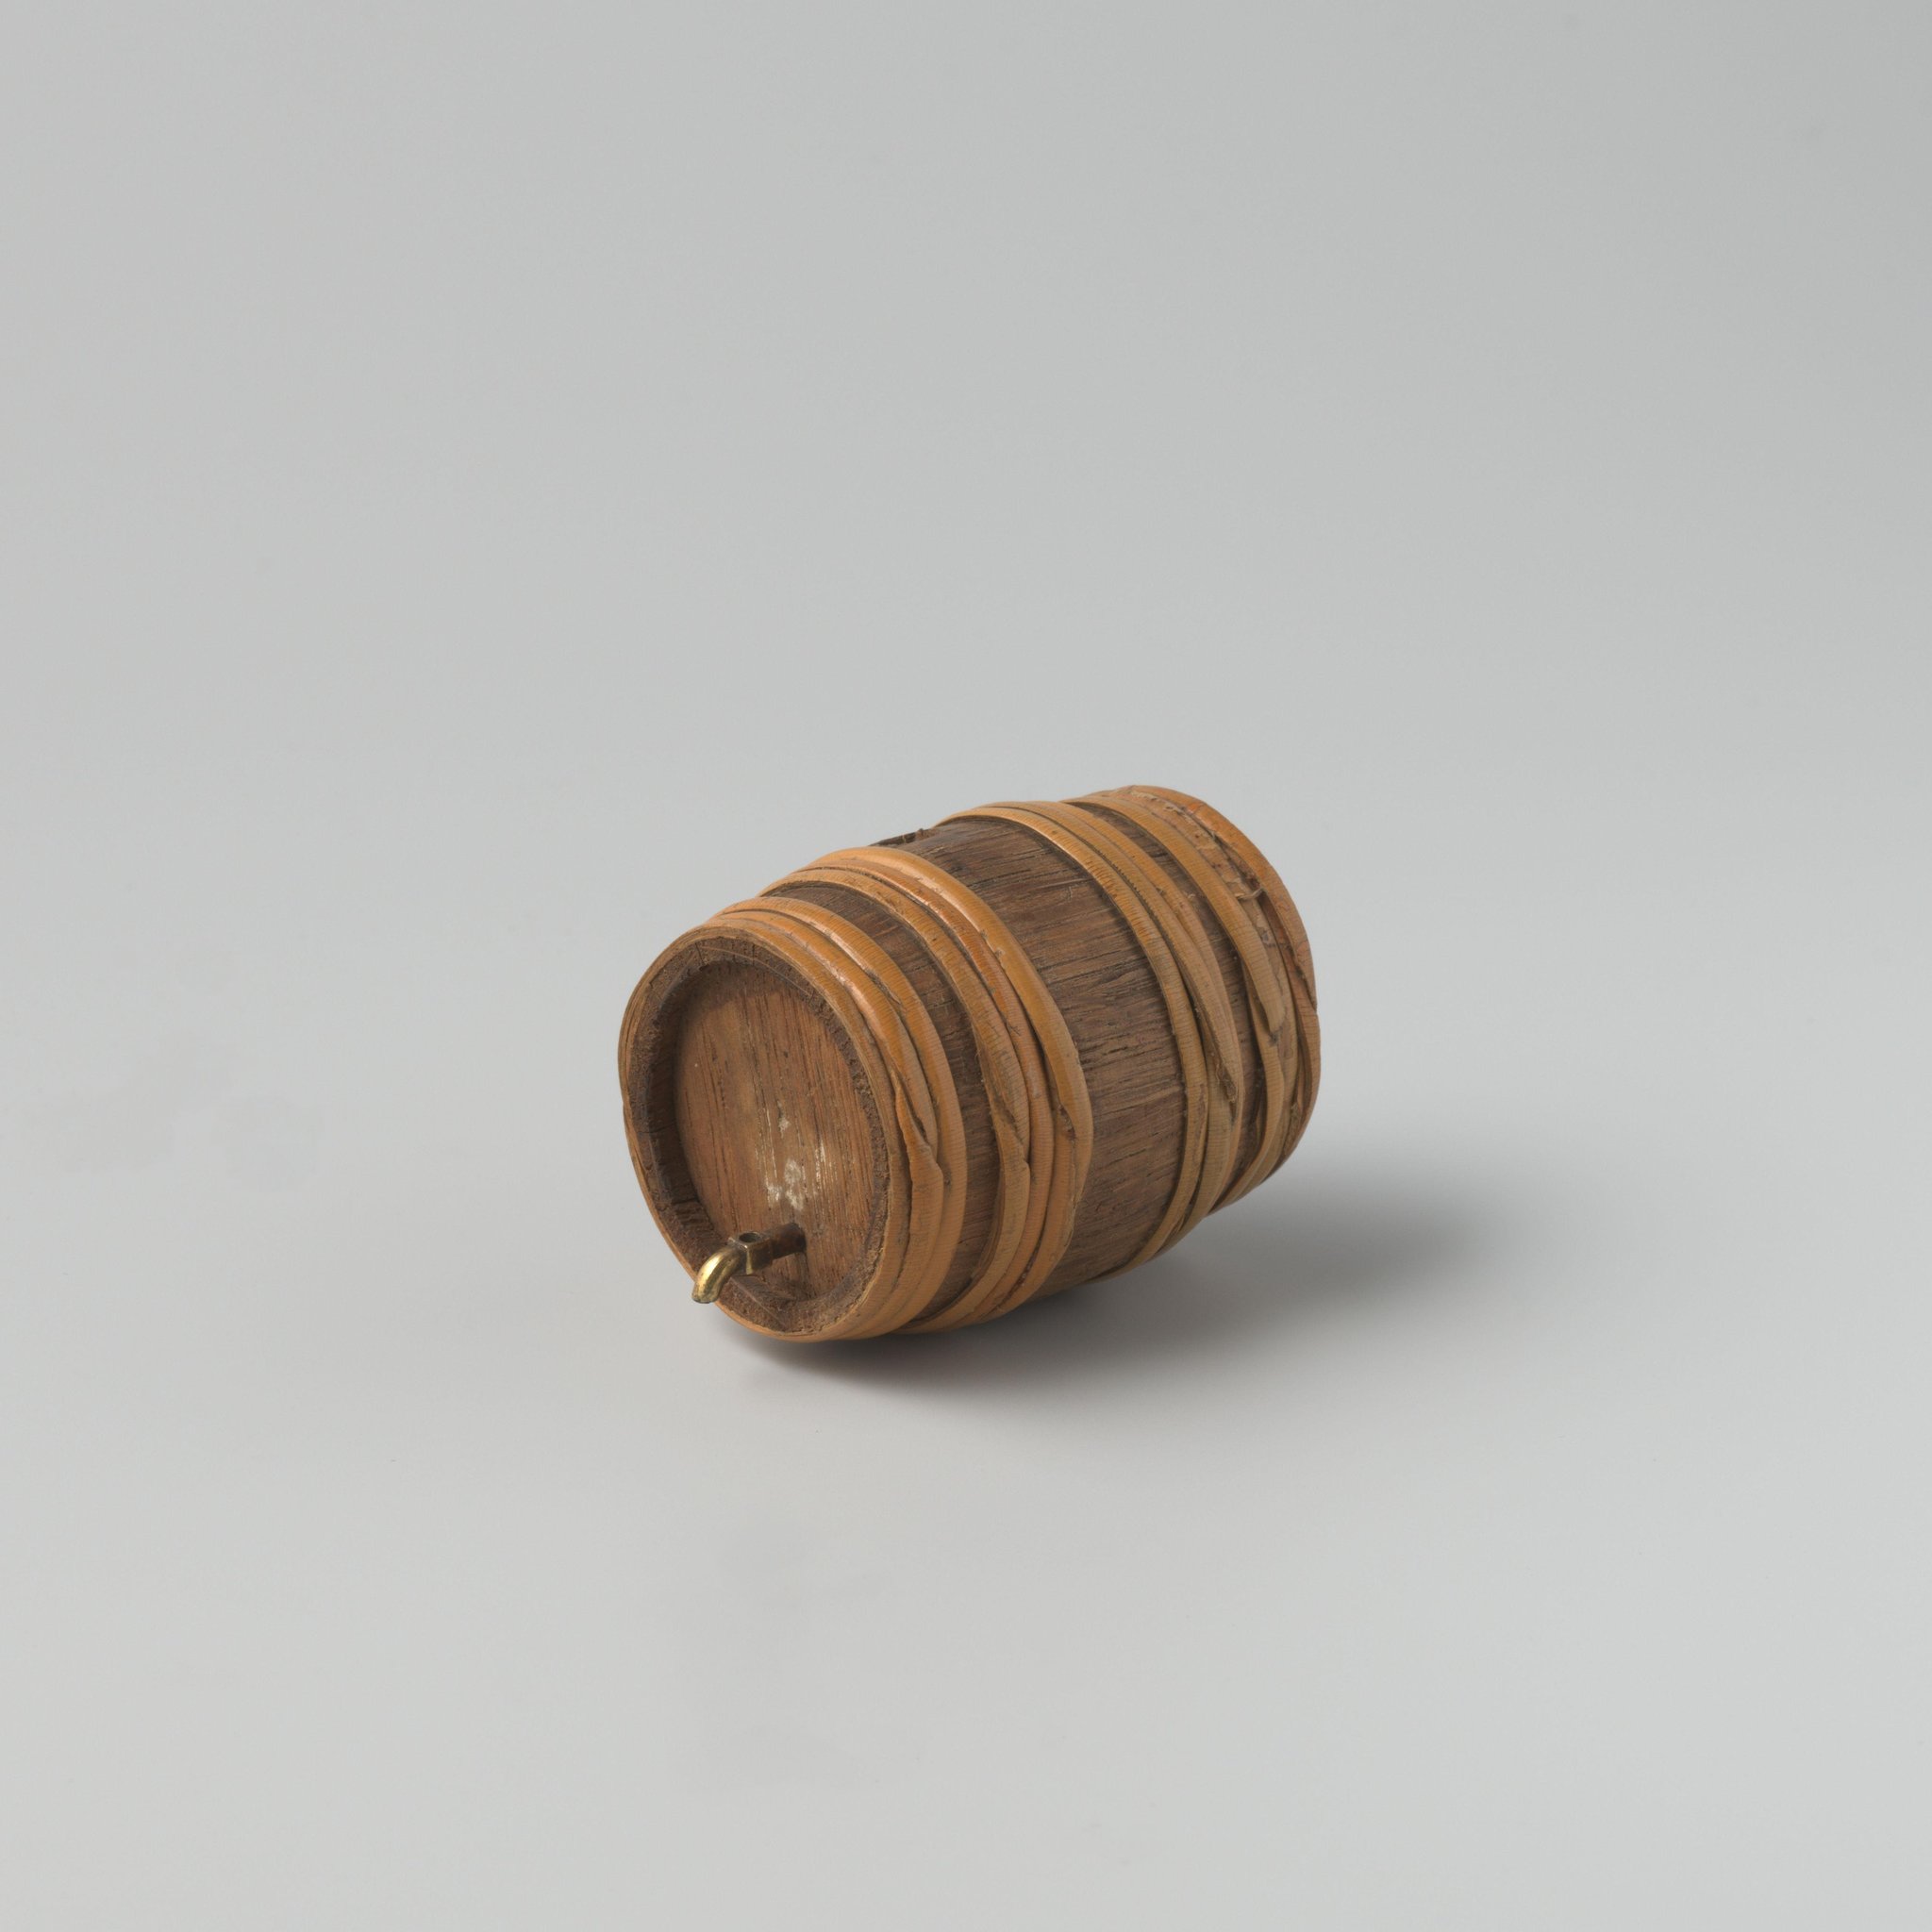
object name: wijnvat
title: Bier- of wijnvat, van eikenhouten duigen, omwonden door 4 x 3 hoepels van rotan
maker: Anonymous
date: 1690-1710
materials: brass, wood, rattan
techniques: gilding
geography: amsterdam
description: Bier- of wijnvat, van eikenhouten duigen, omwonden door 4 x 3 hoepels van rotan. Op de voorkant is met witte verf een zwaantje geschilderd.